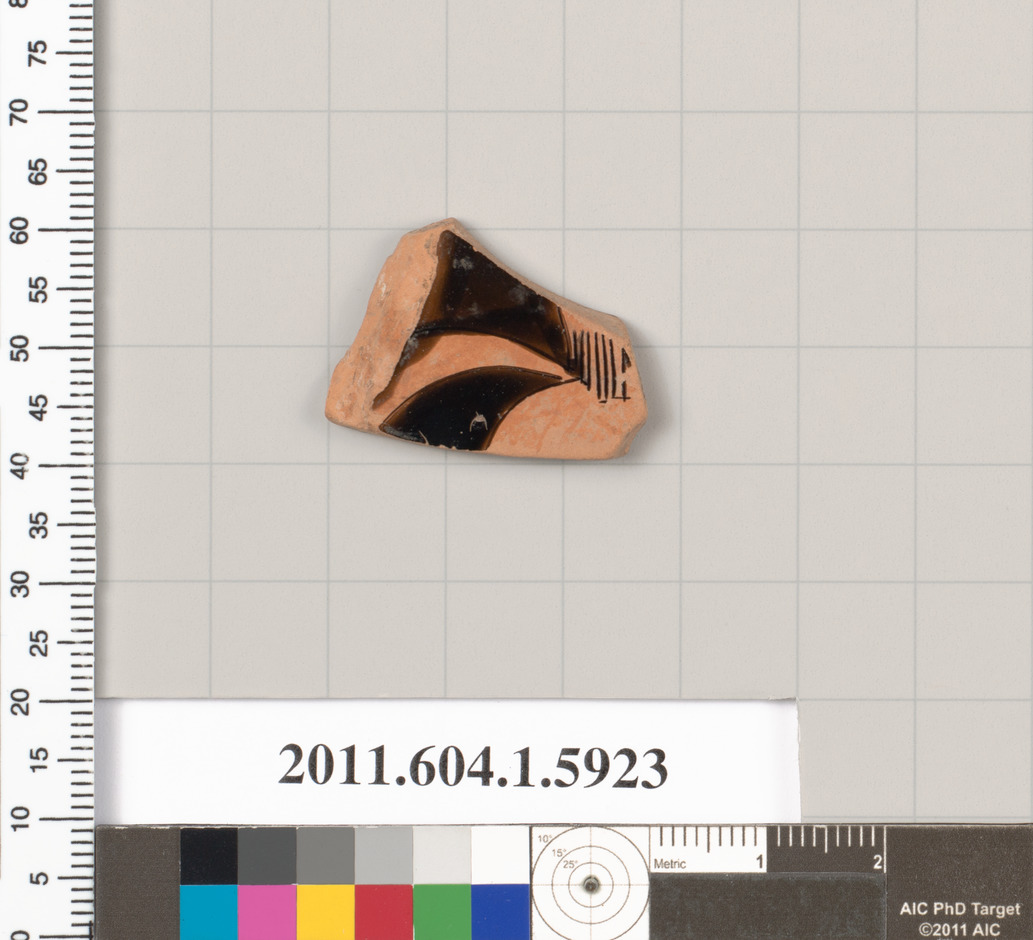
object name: kylix fragment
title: Terracotta fragment of a kylix (drinking cup)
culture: greek, attic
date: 520-510 BCE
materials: terracotta